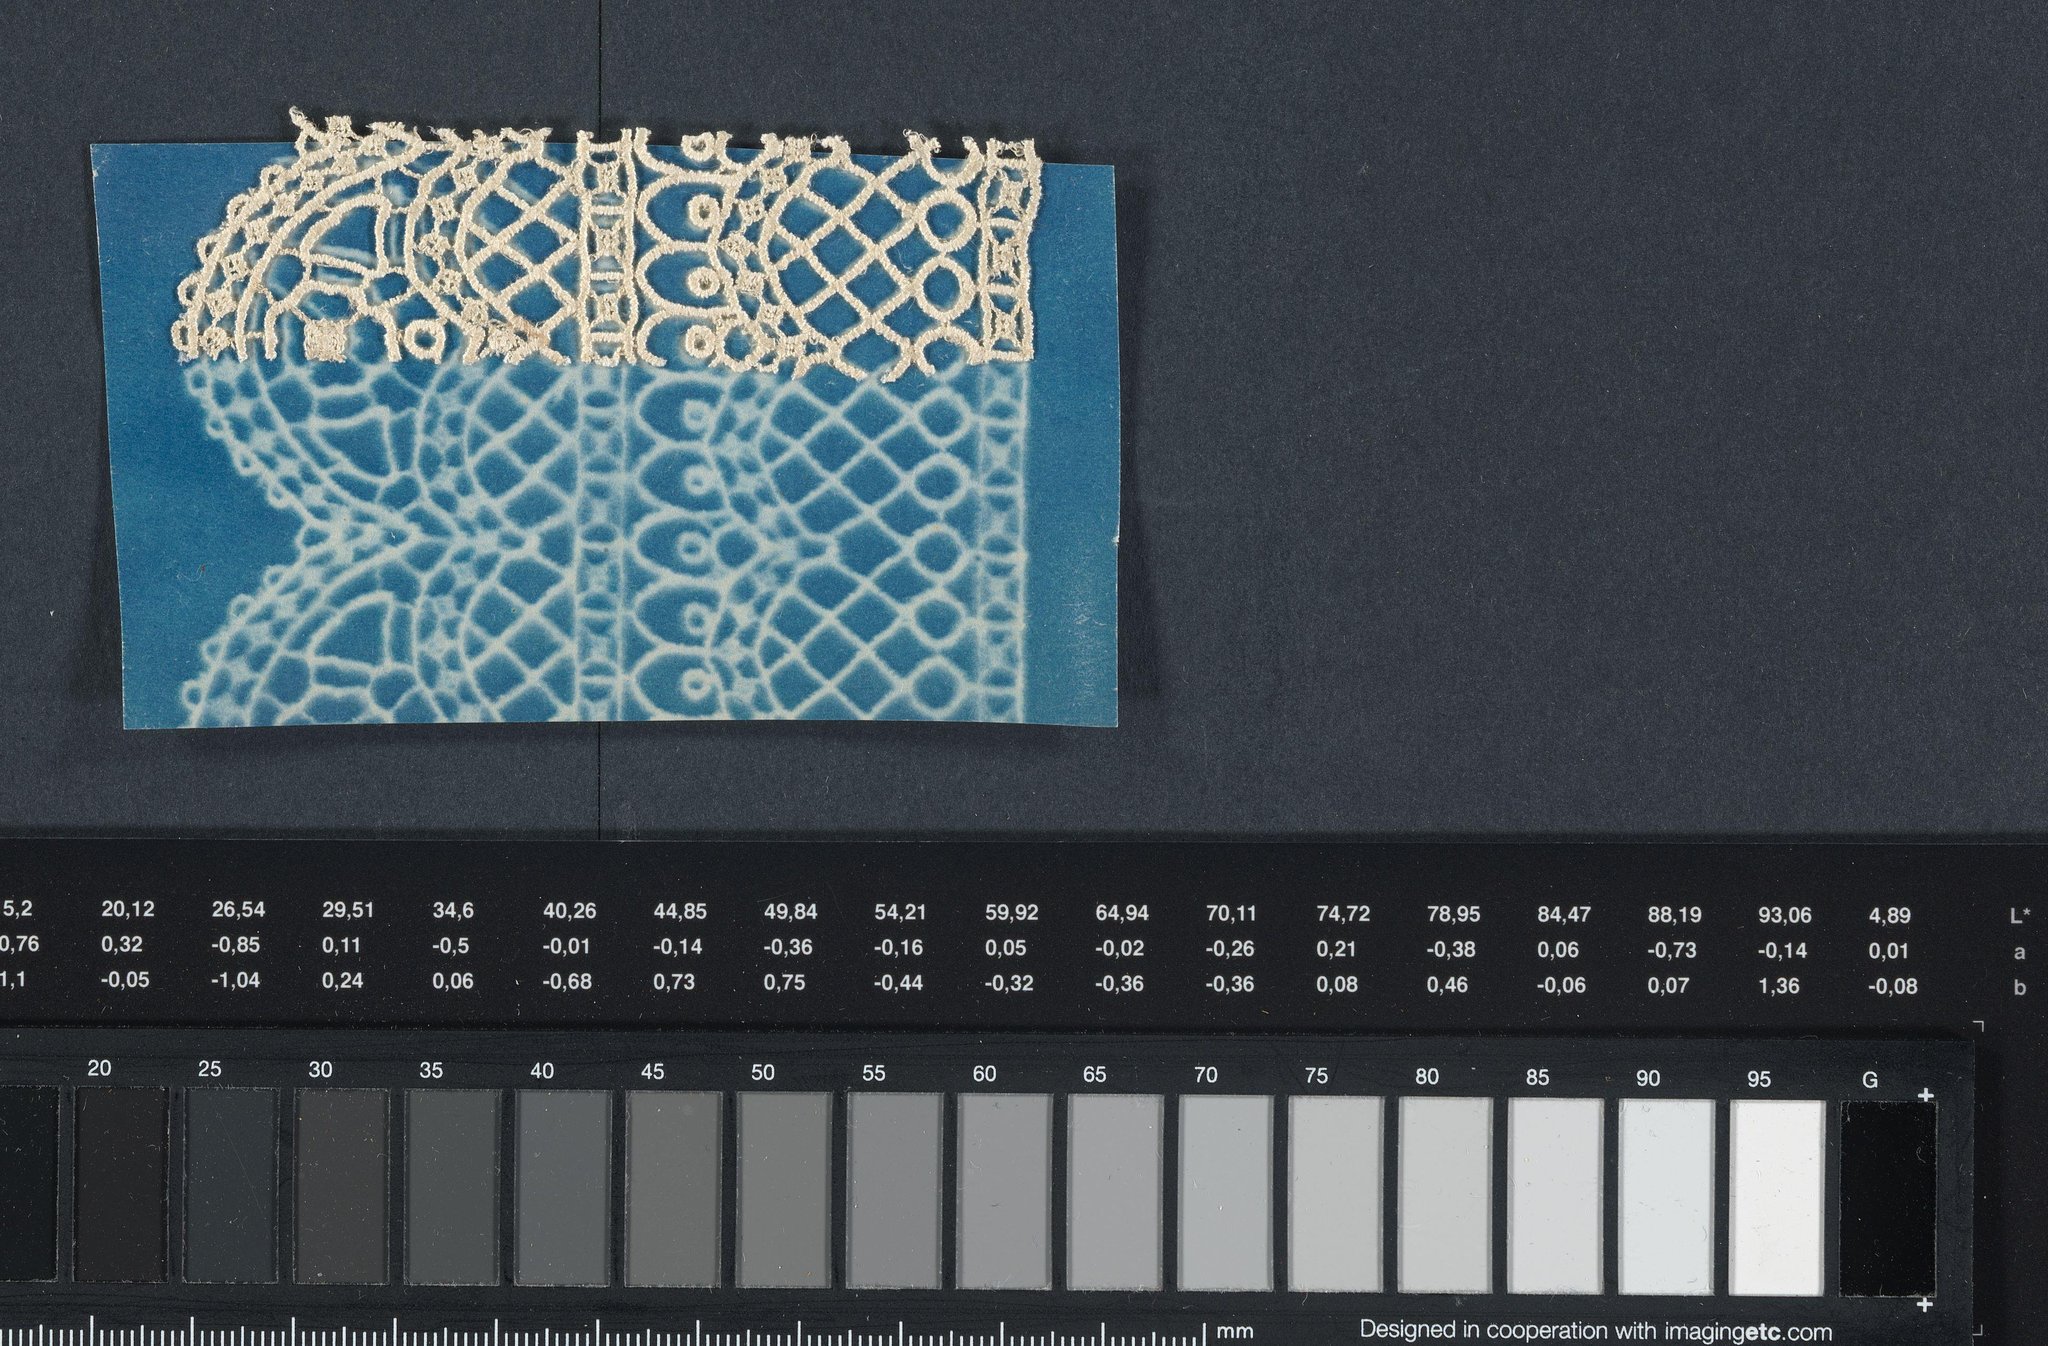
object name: photogram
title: Kant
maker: Anonymous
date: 1900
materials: paper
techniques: cyanotype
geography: france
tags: lace